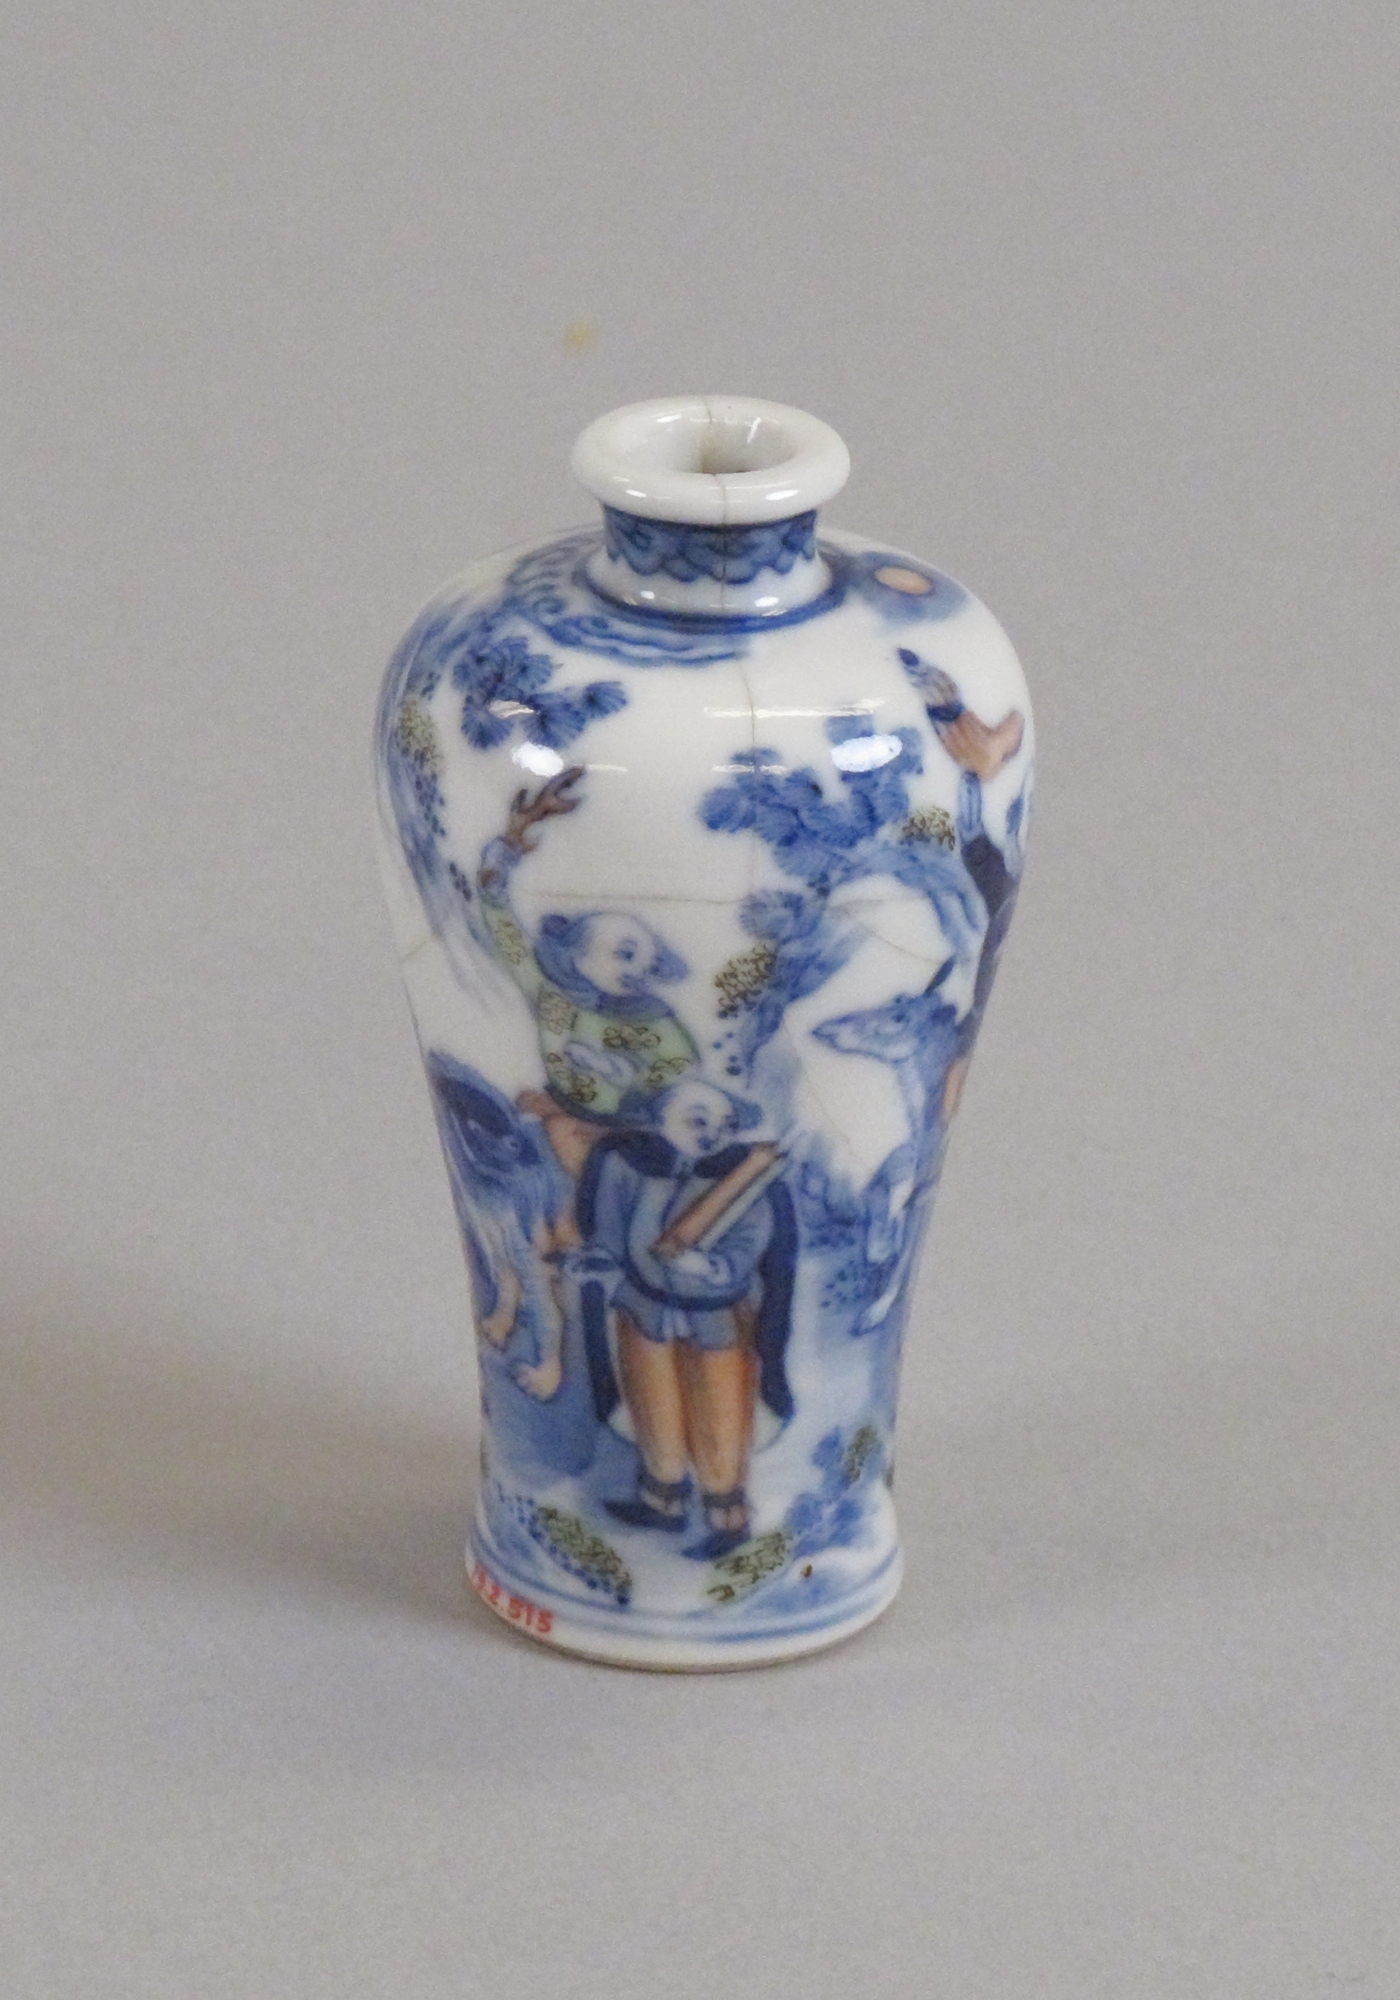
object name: vase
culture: chinese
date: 1736-1795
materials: enamel, porcelain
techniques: overglaze, painting, polychrome, underglaze